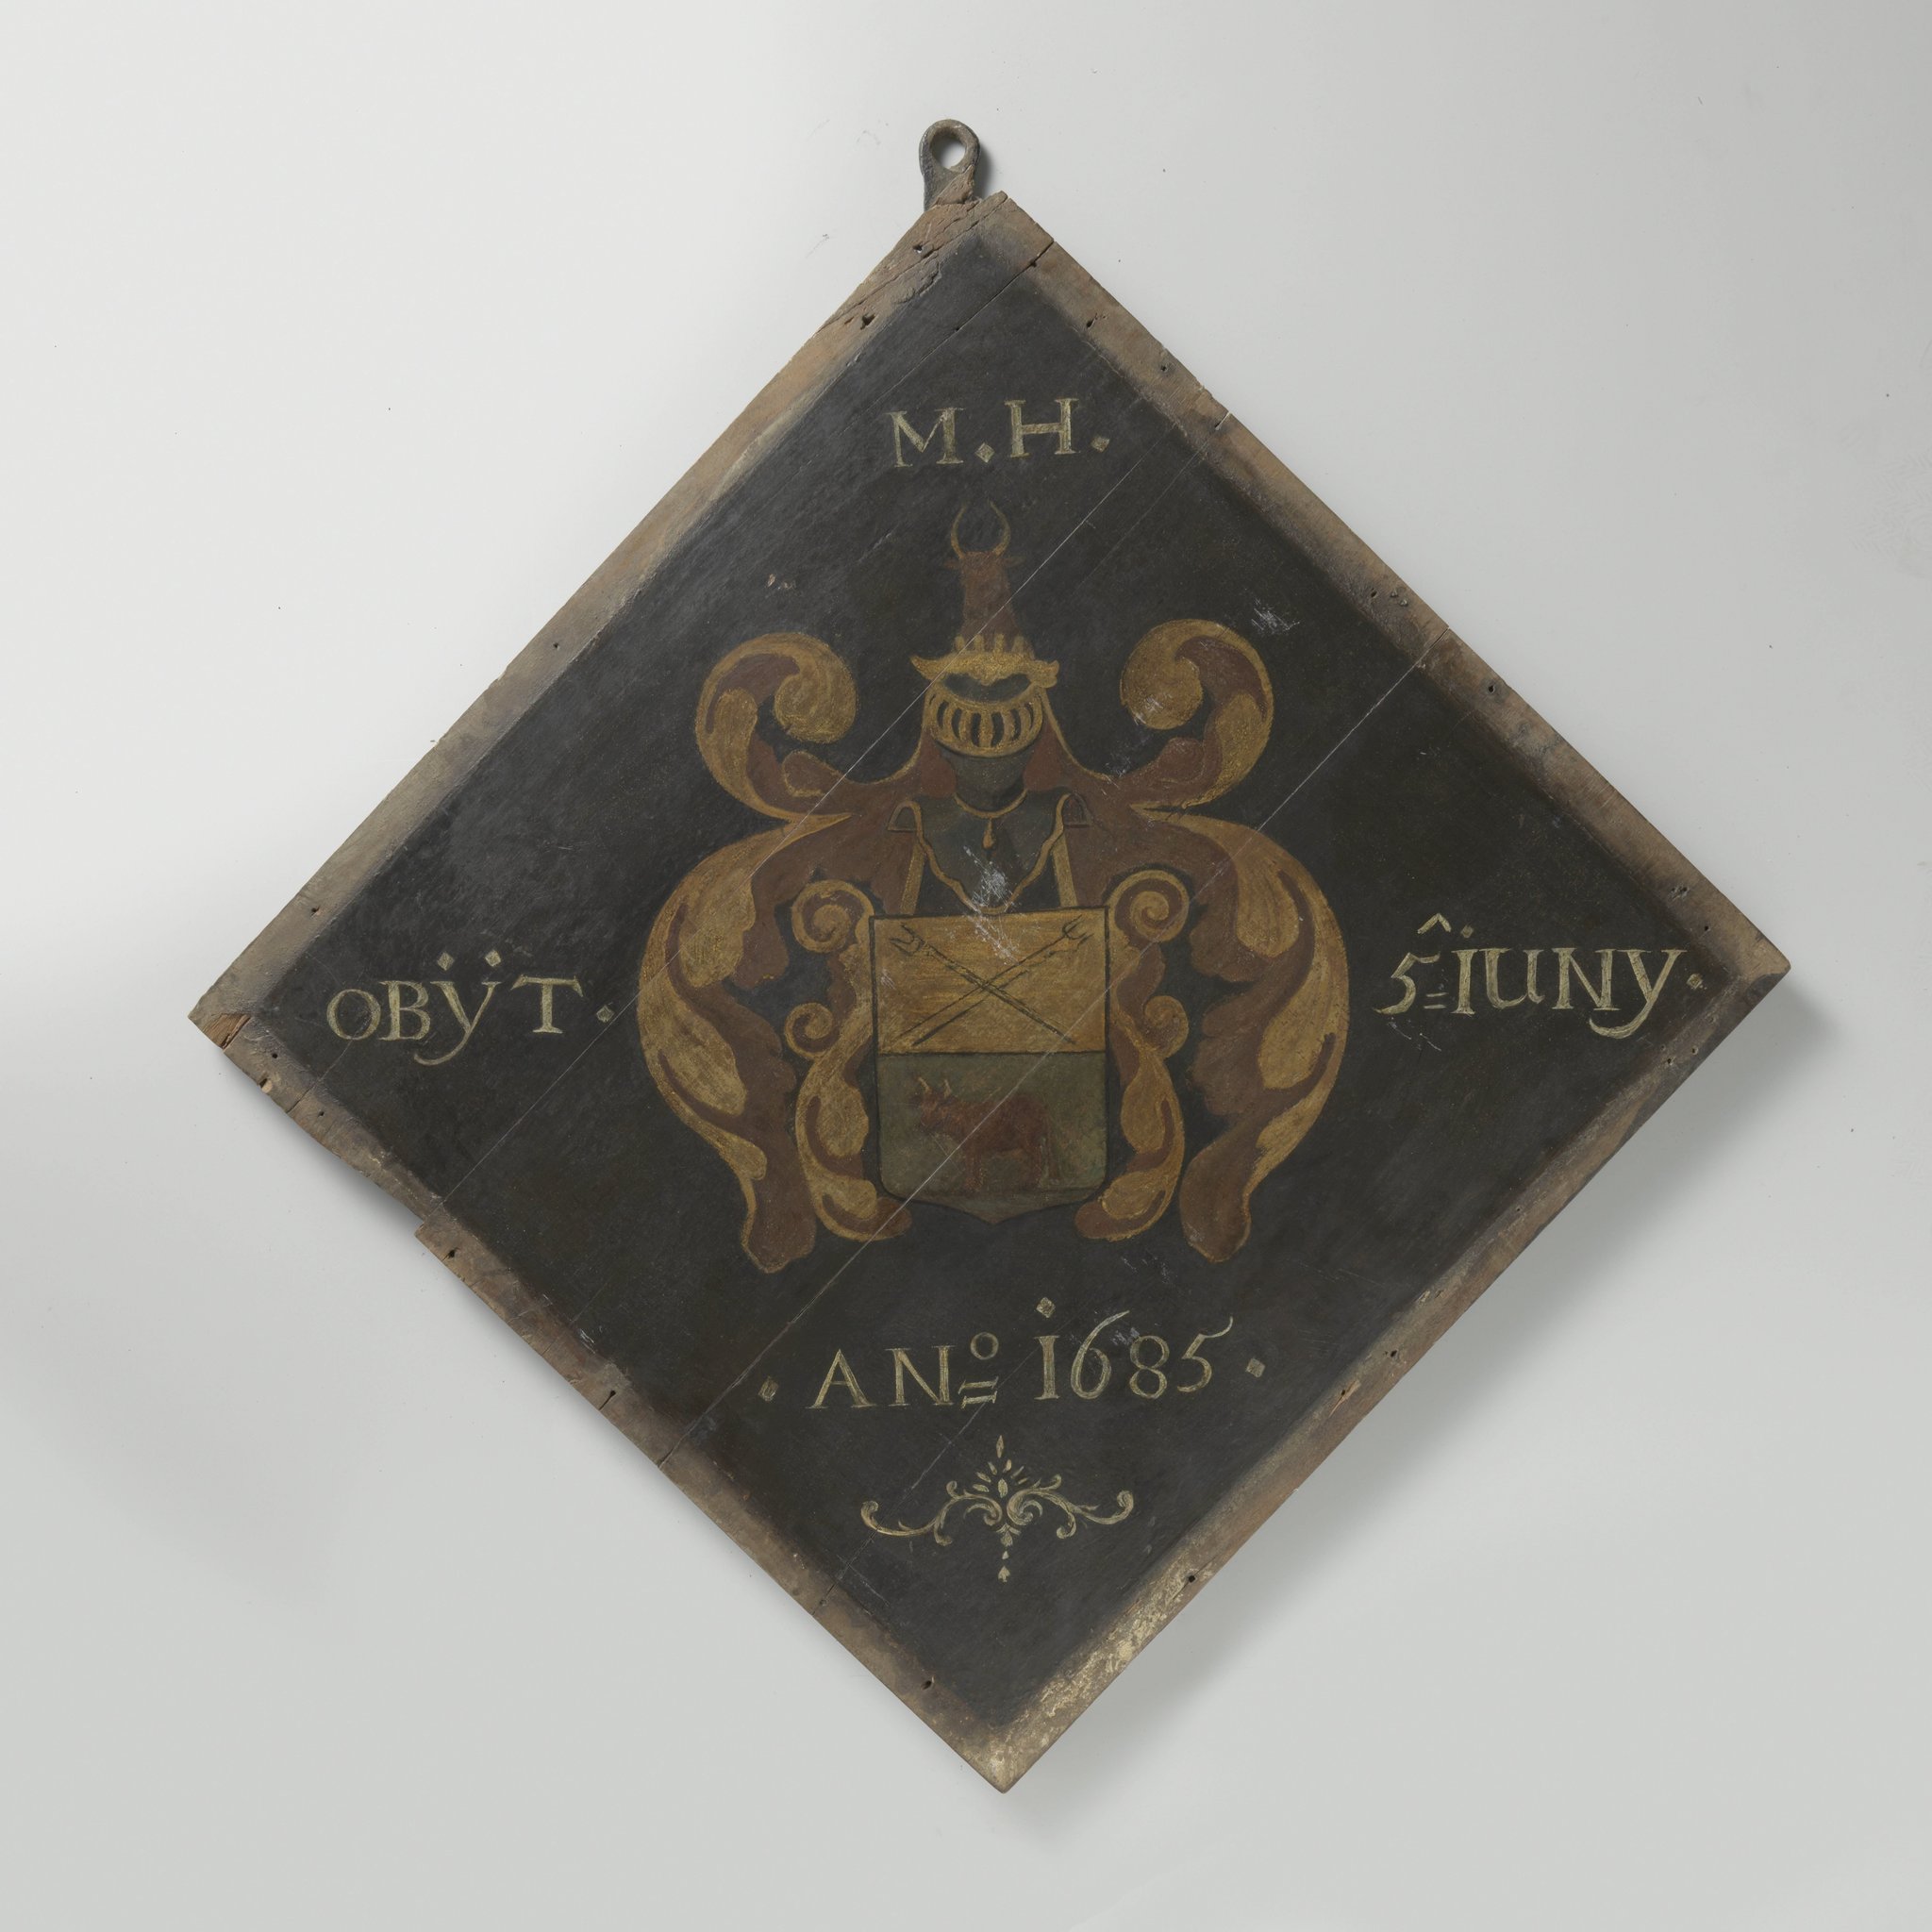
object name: rouwbord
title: Grafbord van Marten Huysman (gestorven 1685), directeur van Bengalen (1683-85)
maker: Anonymous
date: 1767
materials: panel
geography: bengal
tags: armorial bearing, heraldry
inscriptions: inscription: ‘M.H. Obijt 5 Iunij ANo 1685’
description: Grafbord van Marten Huysman. Ruitvormig van indisch hout met zwart geschilderde geprofileerde houten lijst, beschilderd met op zwarte grond een wapen met helm, dekkleden en als helmteken een halve koe. Opschrift in gele letters: 'M.H. Obijt 5 Iunij ANo 1685'.